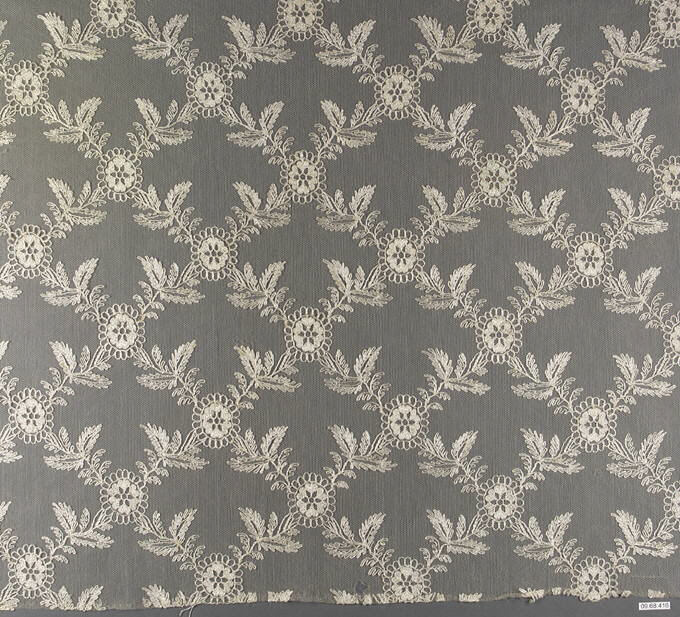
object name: piece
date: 1801-1900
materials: silk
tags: flowers,leaves